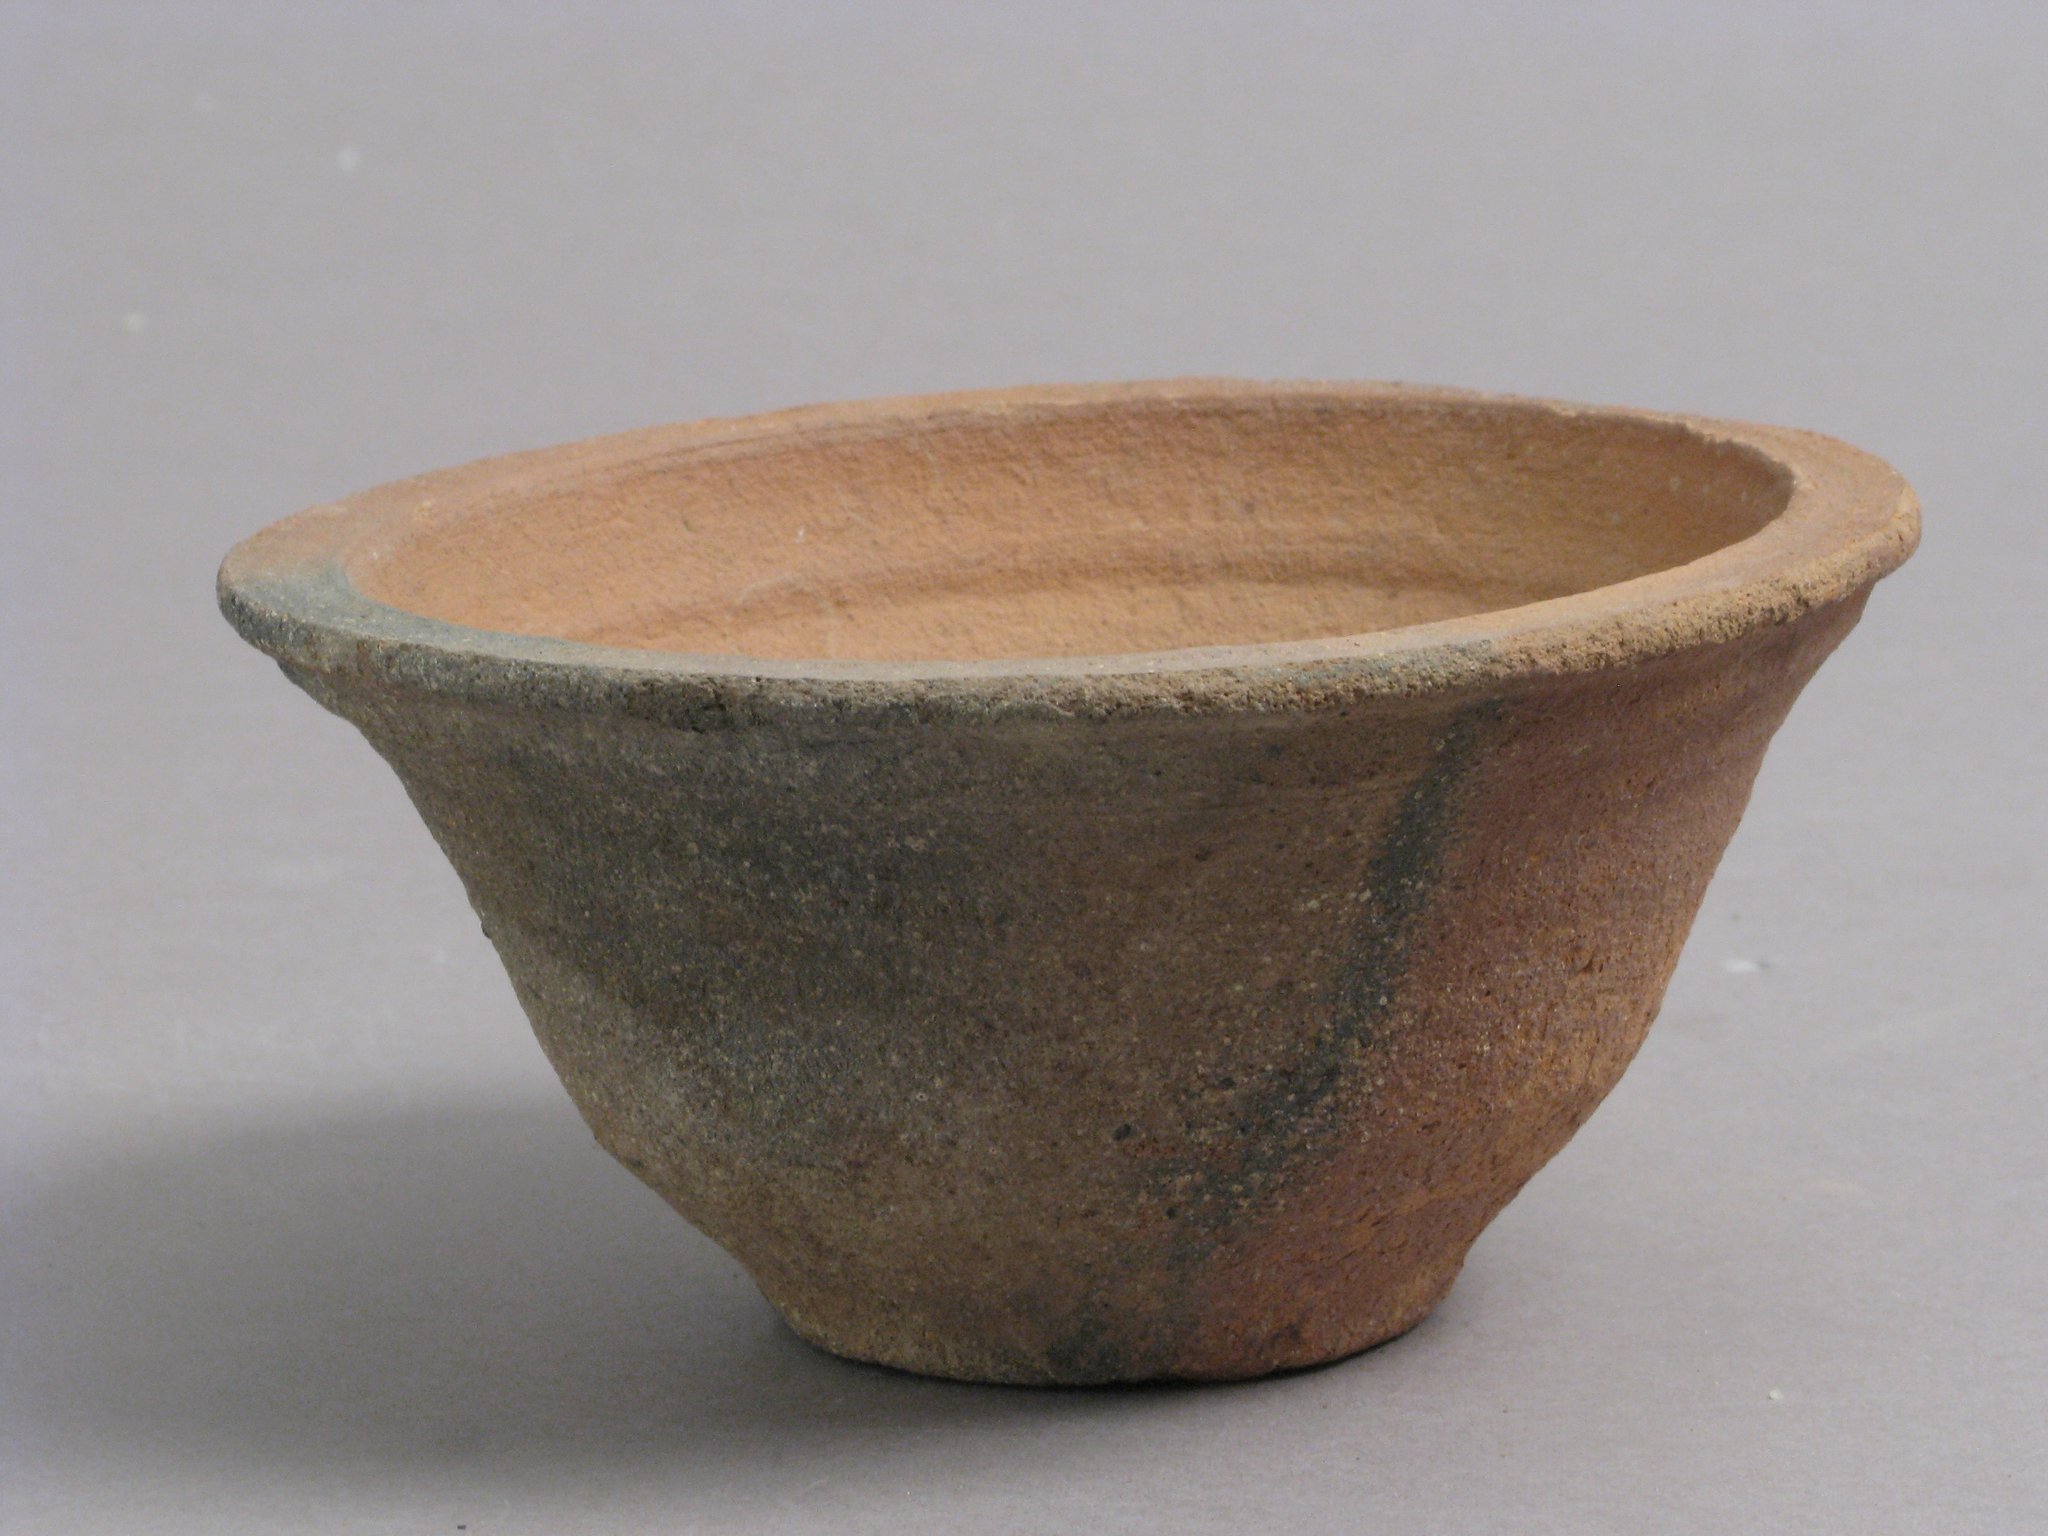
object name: bowl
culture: coptic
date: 301-700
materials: earthenware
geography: egypt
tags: bowls